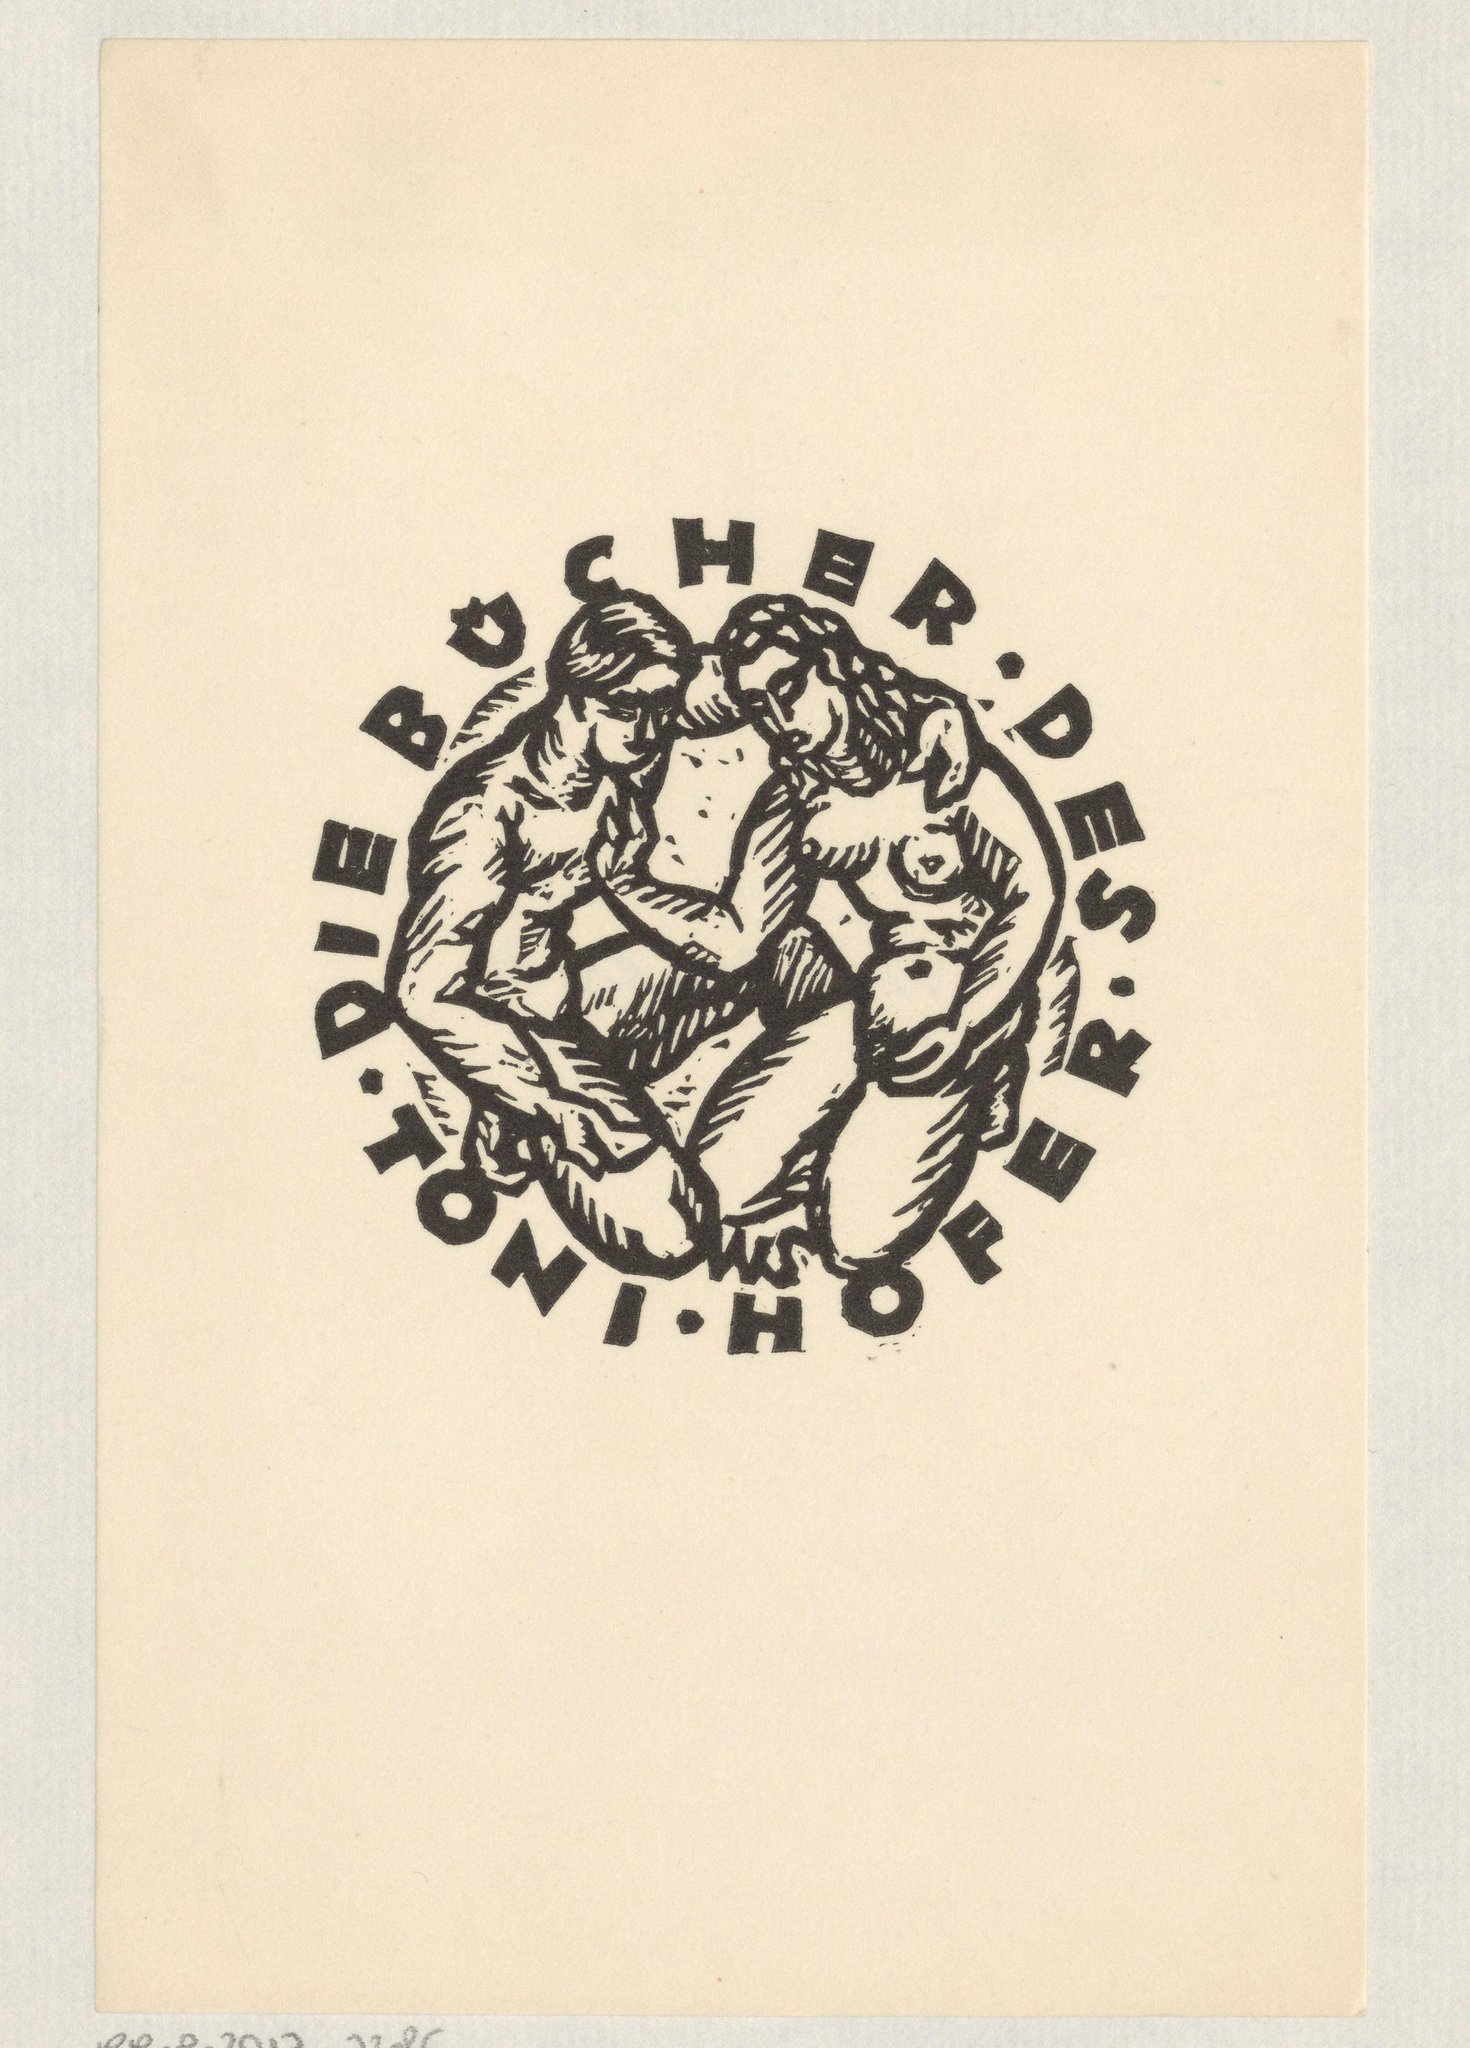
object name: bookplate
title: Die Bücher des/ Toni Hofer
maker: wilhelm sauer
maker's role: print maker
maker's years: 1892-1930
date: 1930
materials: paper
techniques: woodcut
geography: austria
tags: painter, toni hofer, woman (showing herself) undressed, quasi-nude, squatting, crouching figure